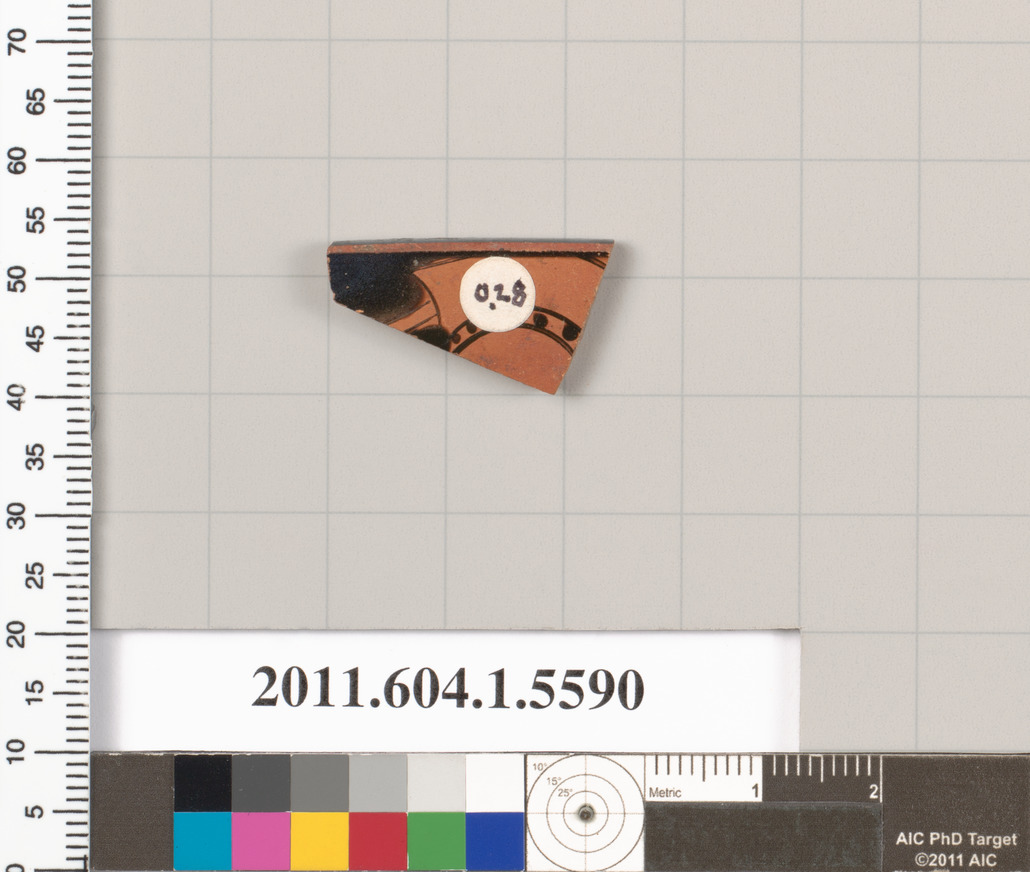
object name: kylix fragment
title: Terracotta rim fragment of a kylix (drinking cup)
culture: greek, attic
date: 510-480 BCE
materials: terracotta